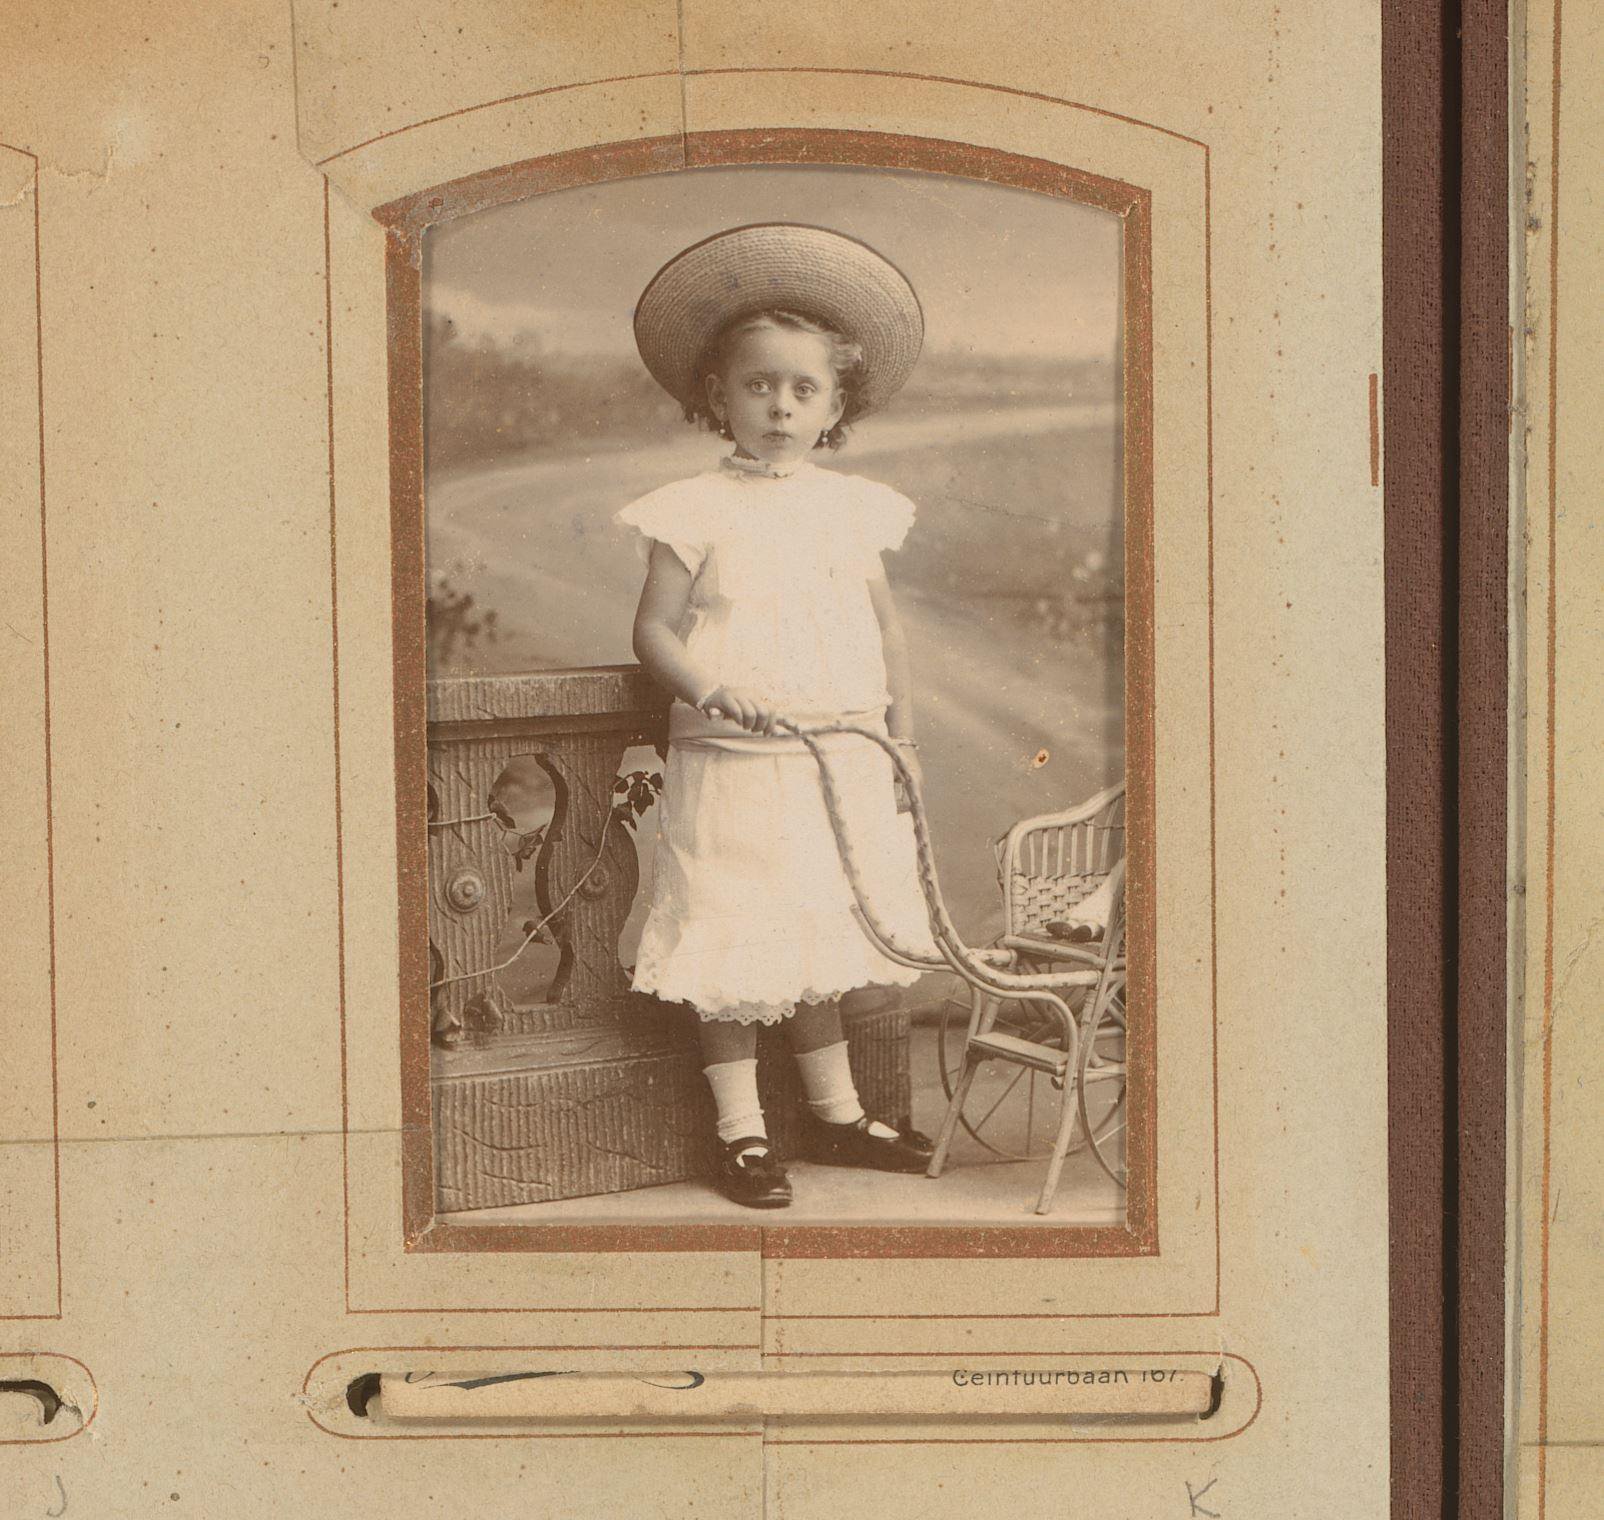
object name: carte de visite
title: Portret van een meisje met een wagen met pop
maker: jean daniel matthieu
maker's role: fotograaf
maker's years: 1865-1926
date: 1890-1907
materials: cardboard, photographic support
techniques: gelatin silver print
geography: amsterdam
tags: historical persons - bb - woman, girl (child between toddler and youth), (playing with) dolls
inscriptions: inscription: ‘Fotografie/ Artistique/ J. D. Matthieu/ Amsterdam/ Ceintuurbaan 167/ Atelier parterre./ Specialiteit in Vergrootingen.’